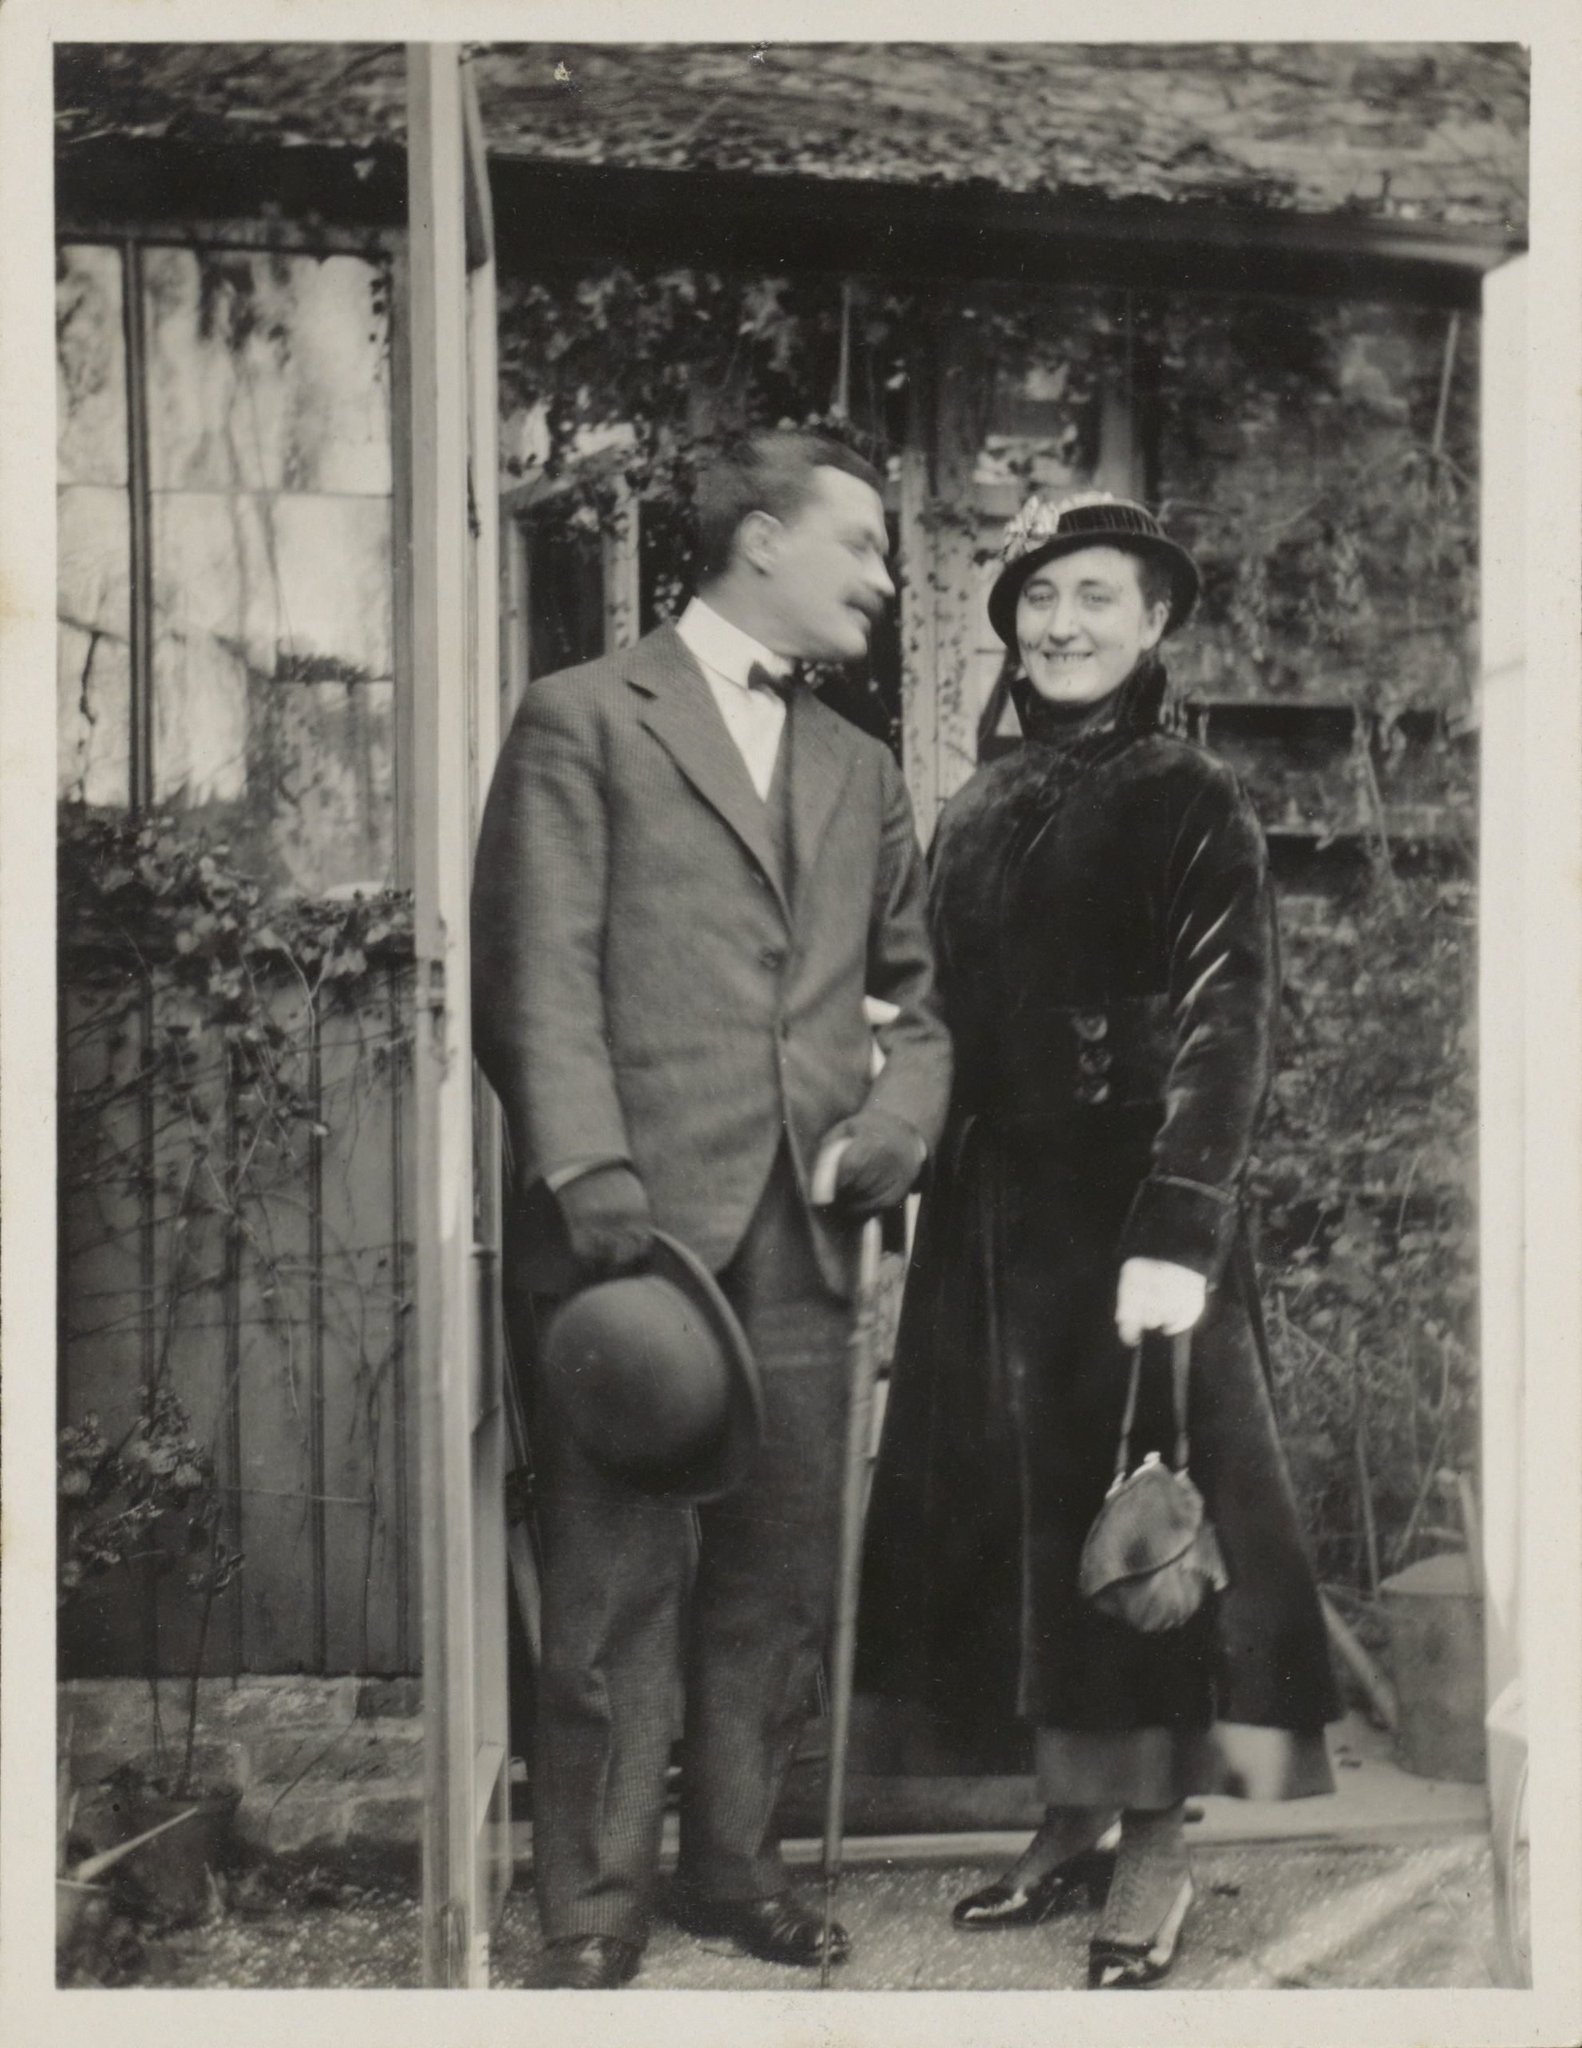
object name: photograph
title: Portret van het echtpaar Schaerer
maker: Anonymous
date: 1900-1920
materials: photographic support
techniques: gelatin silver print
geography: england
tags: marriage, married couple, 'matrimonium', england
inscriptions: inscription: ‘With kindest regards to Mr. & Mrs. Van Gestel from mr. & Mrs. Schaerer’